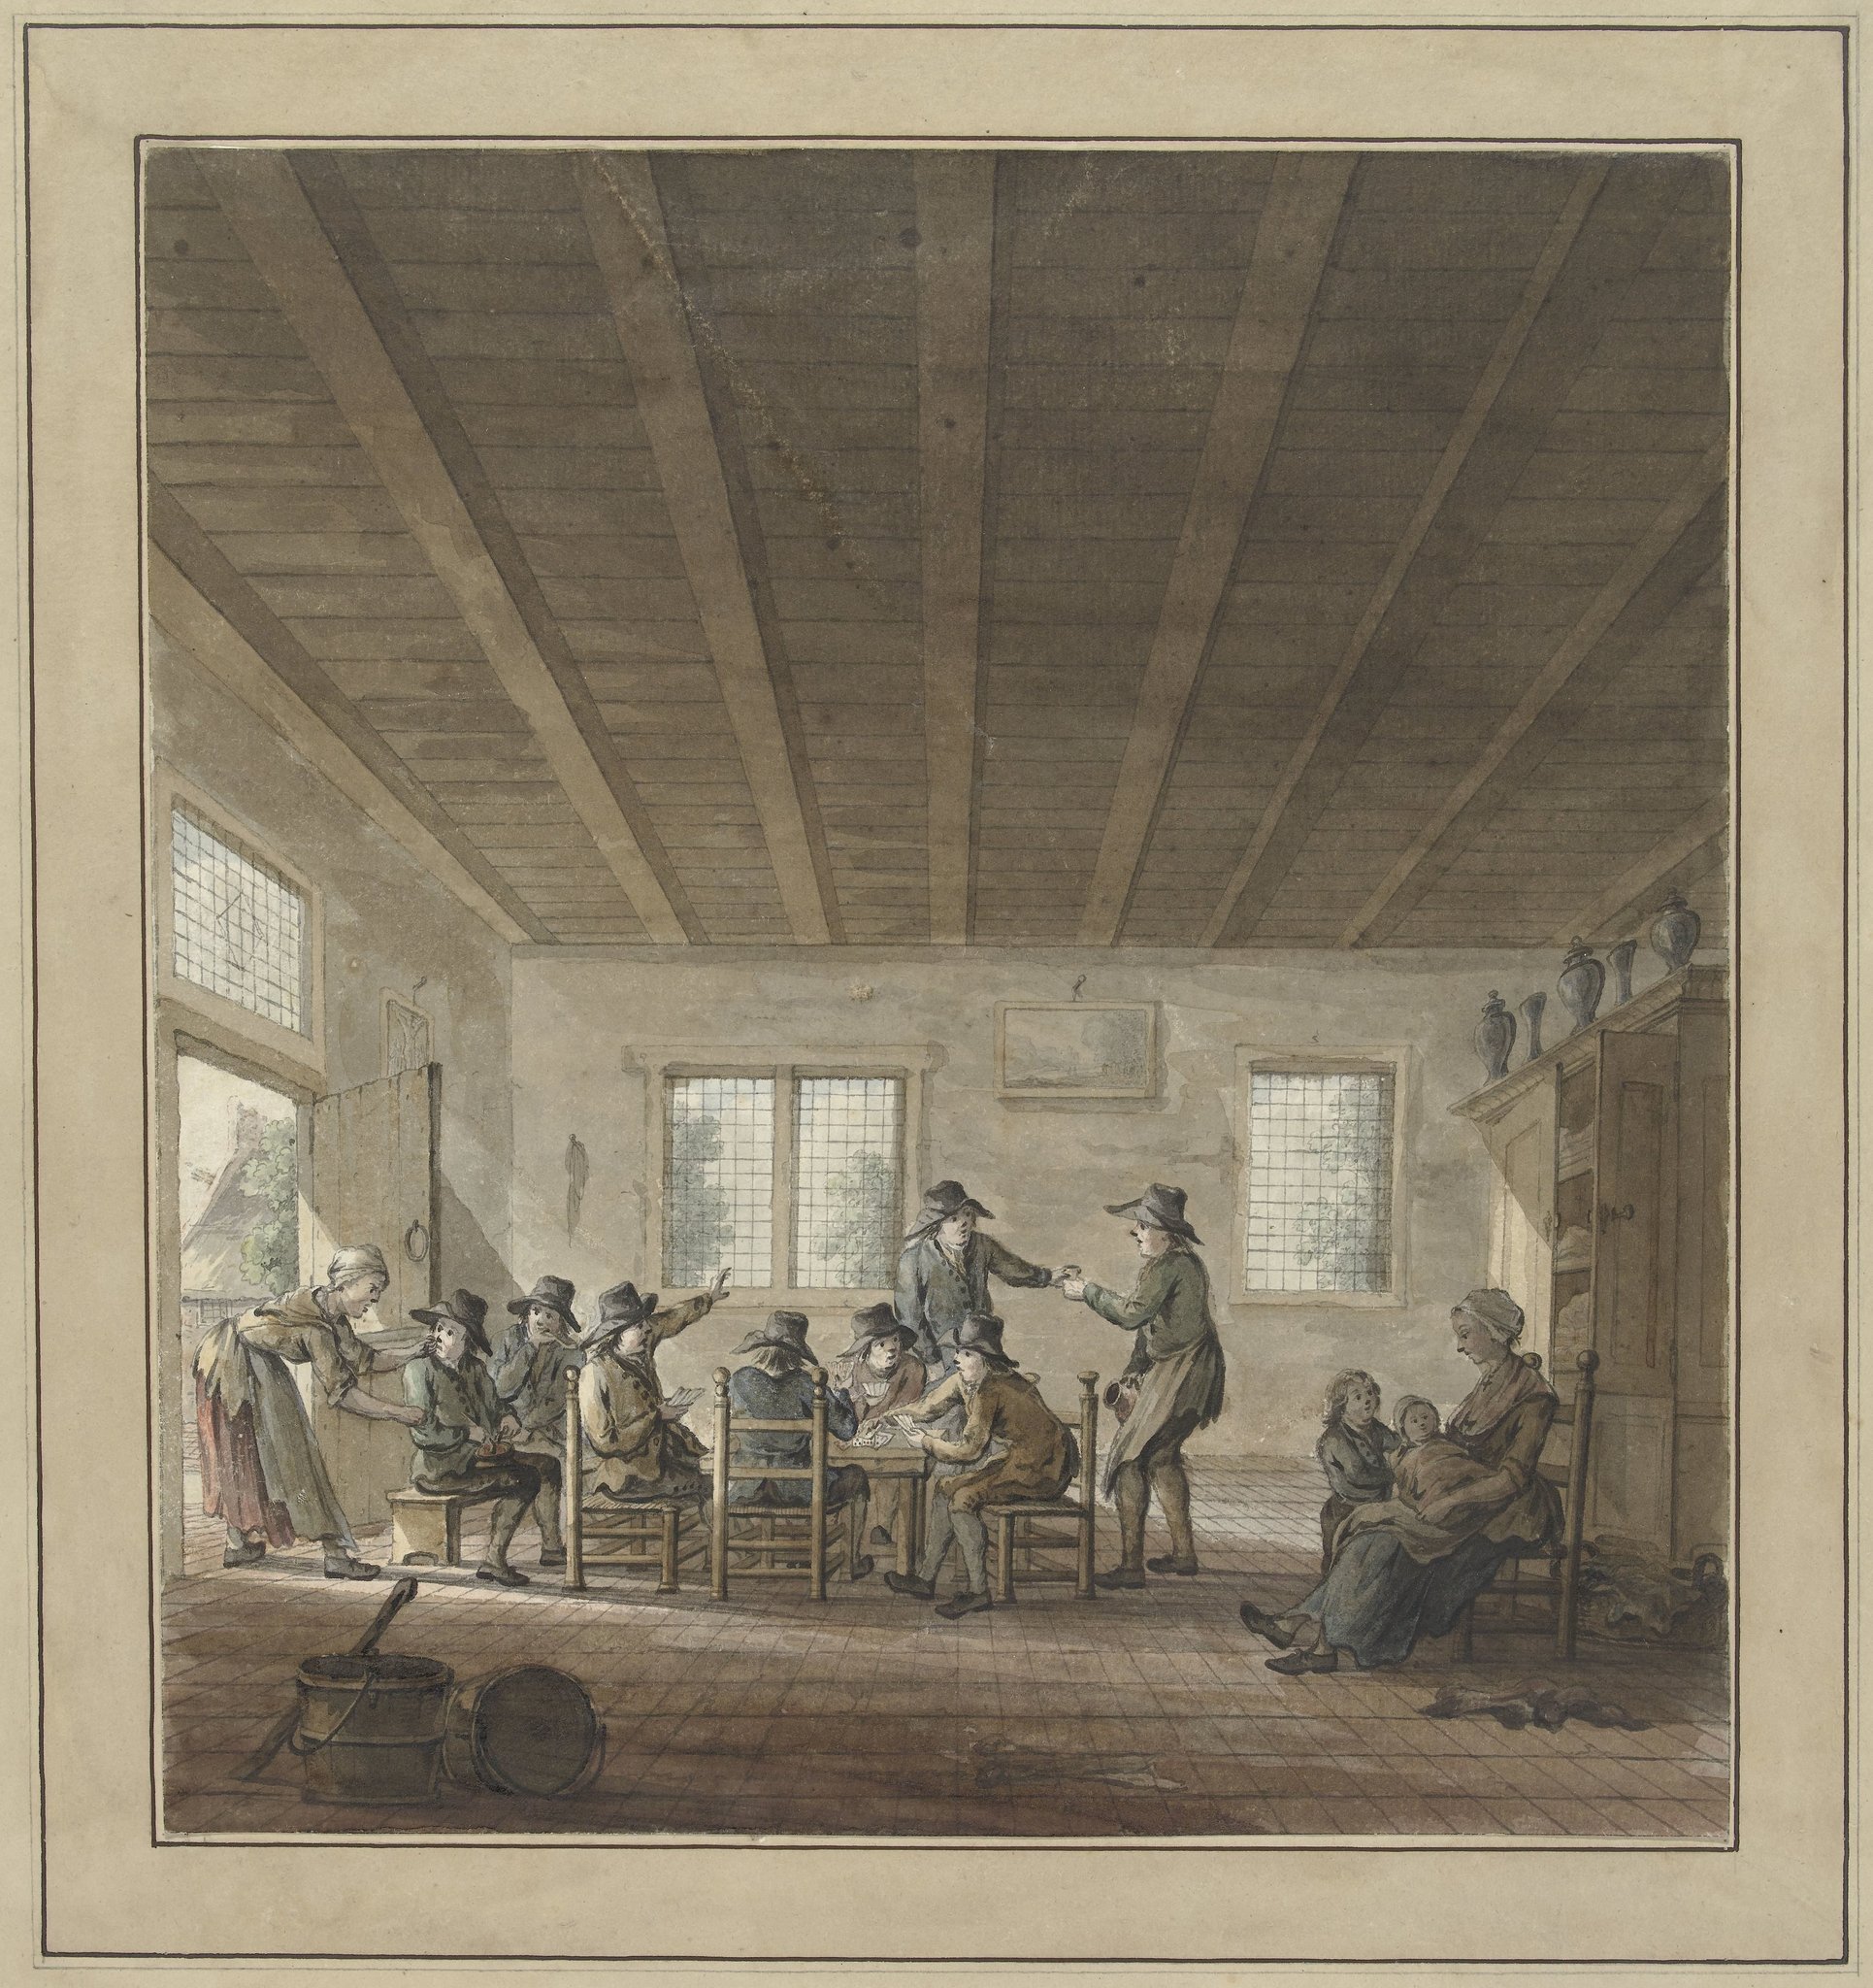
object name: drawing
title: Herberginterieur met een groep kaartende en drinkende boeren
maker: Anonymous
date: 1750-1799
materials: paper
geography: netherlands